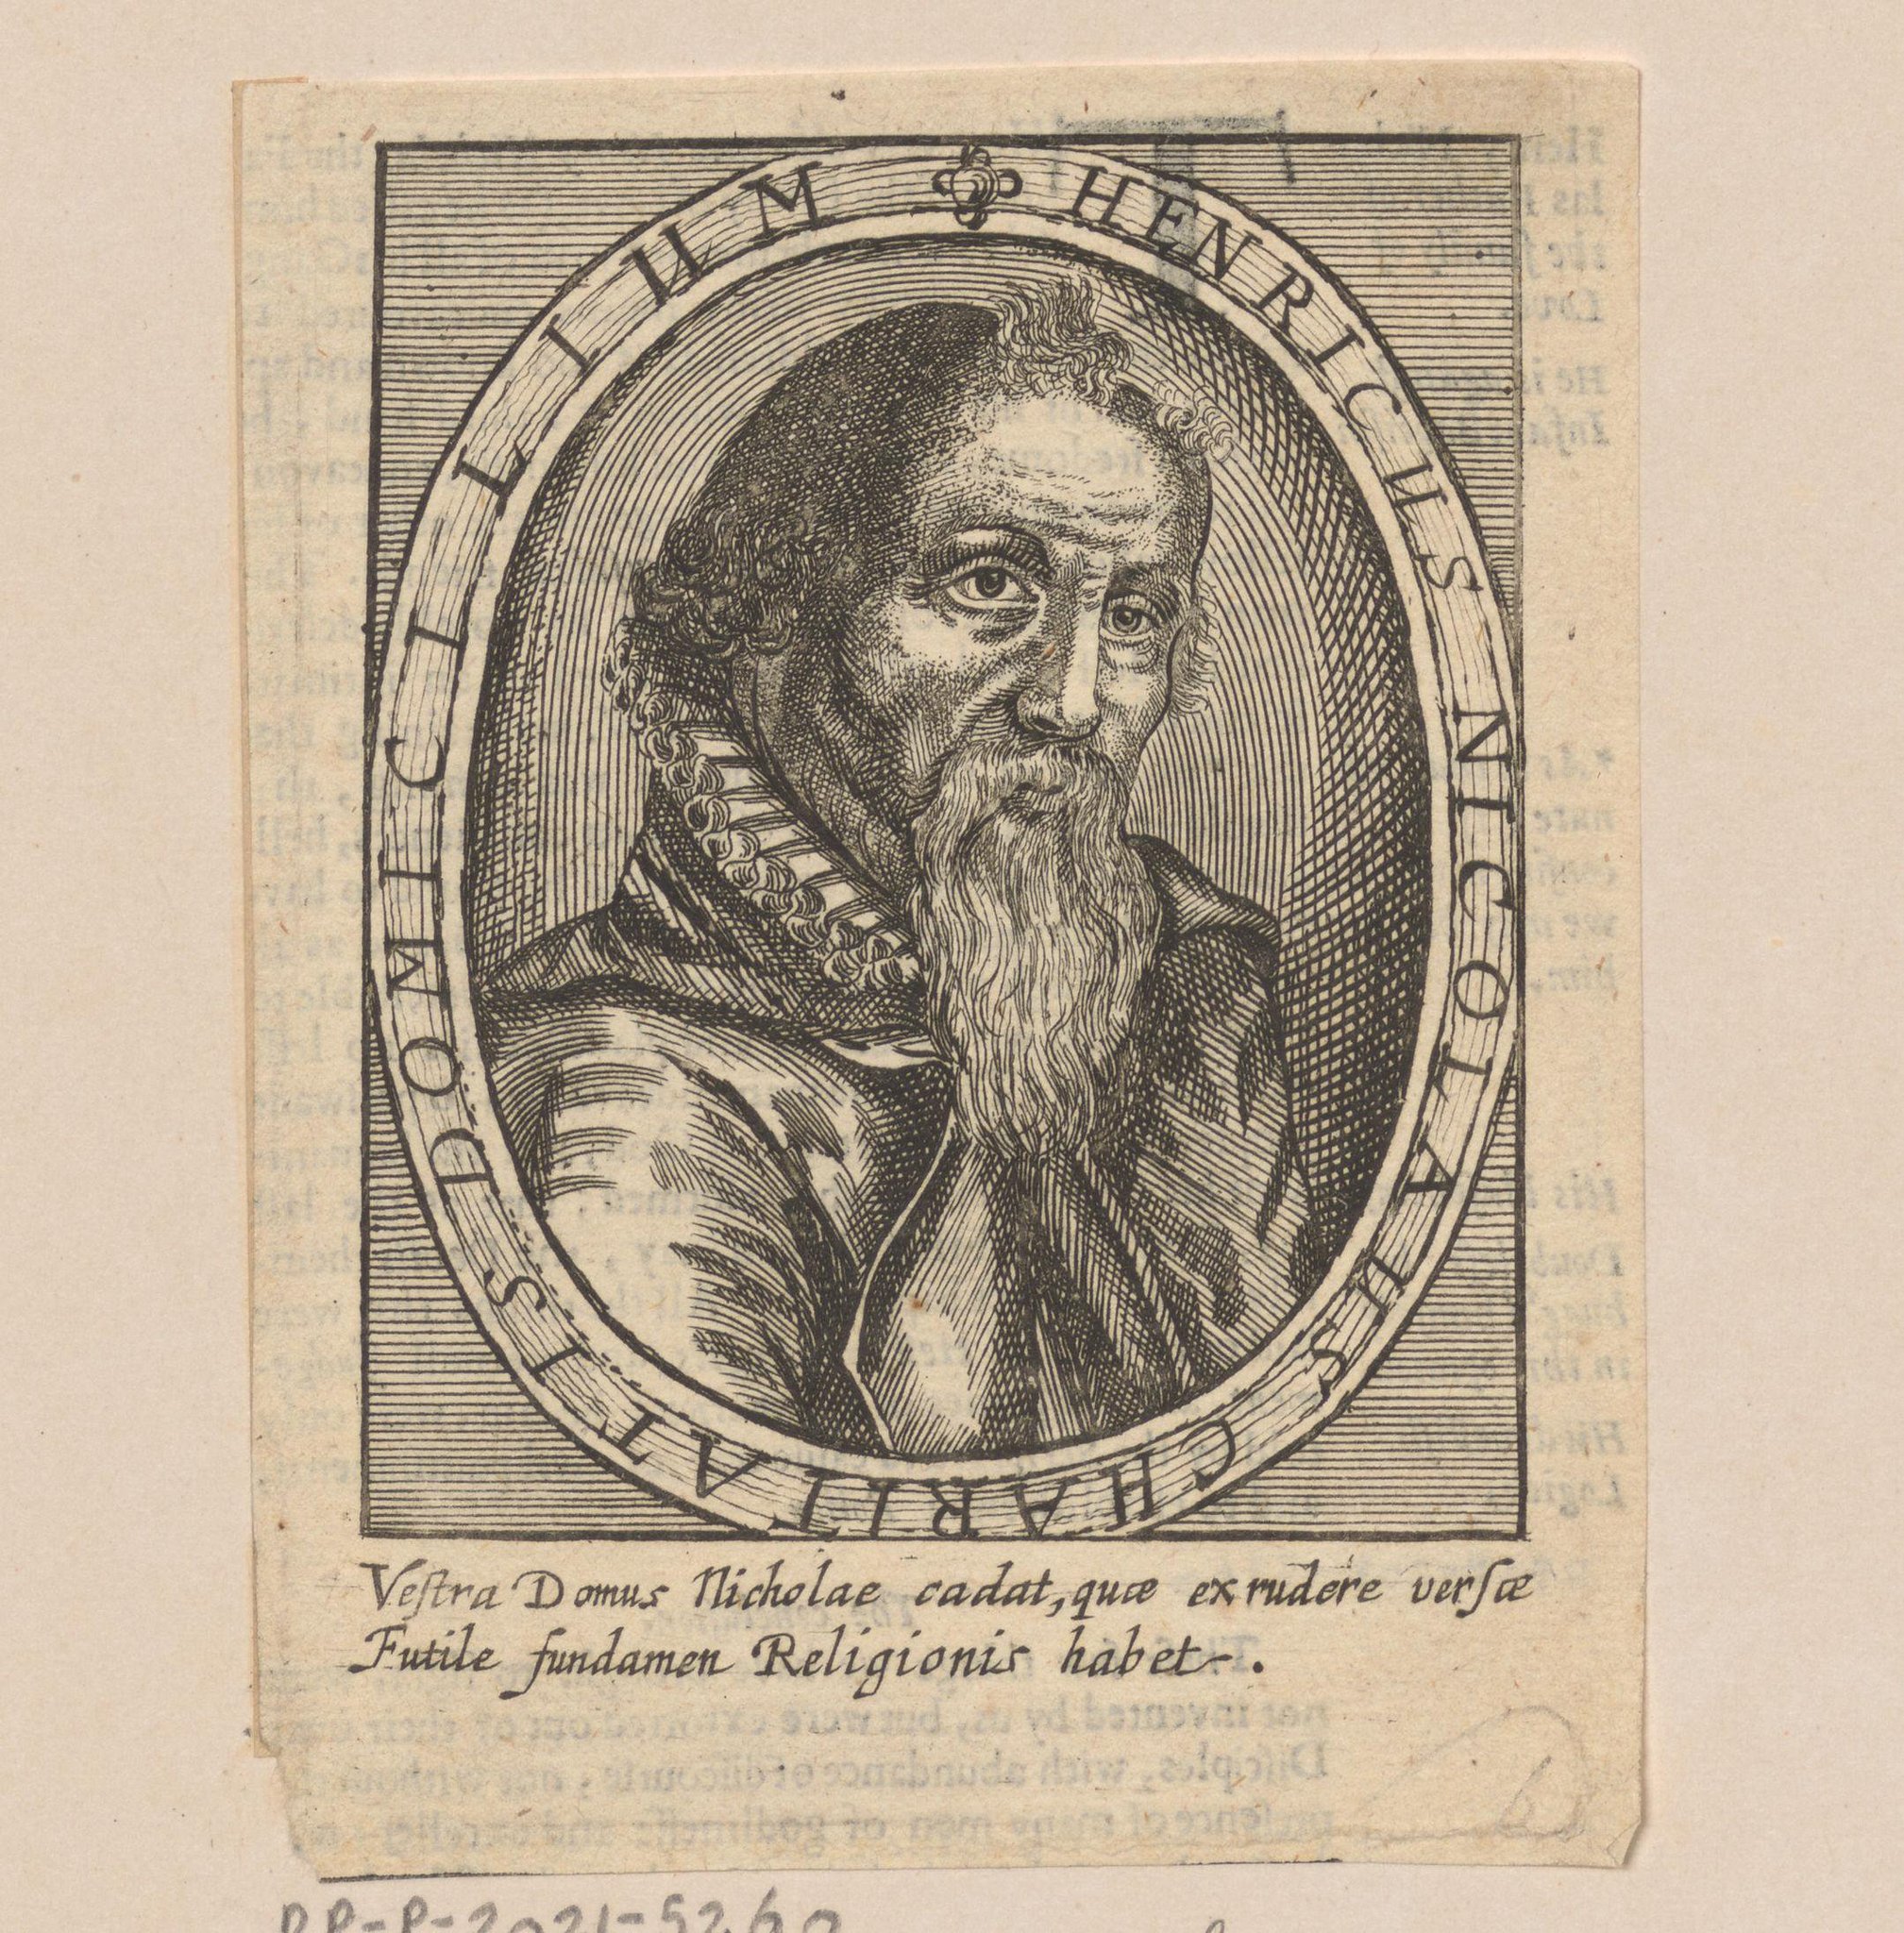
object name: print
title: Portret van Hendrik Niclaes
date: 1664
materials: paper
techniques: etching, letterpress printing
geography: london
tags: christian sects, historical persons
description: Prent uit: Ross, Alexander. Pansebia. Or a View of All Religions in the World (...). Londen: Sarah Griffin, 1664, dl. 2.